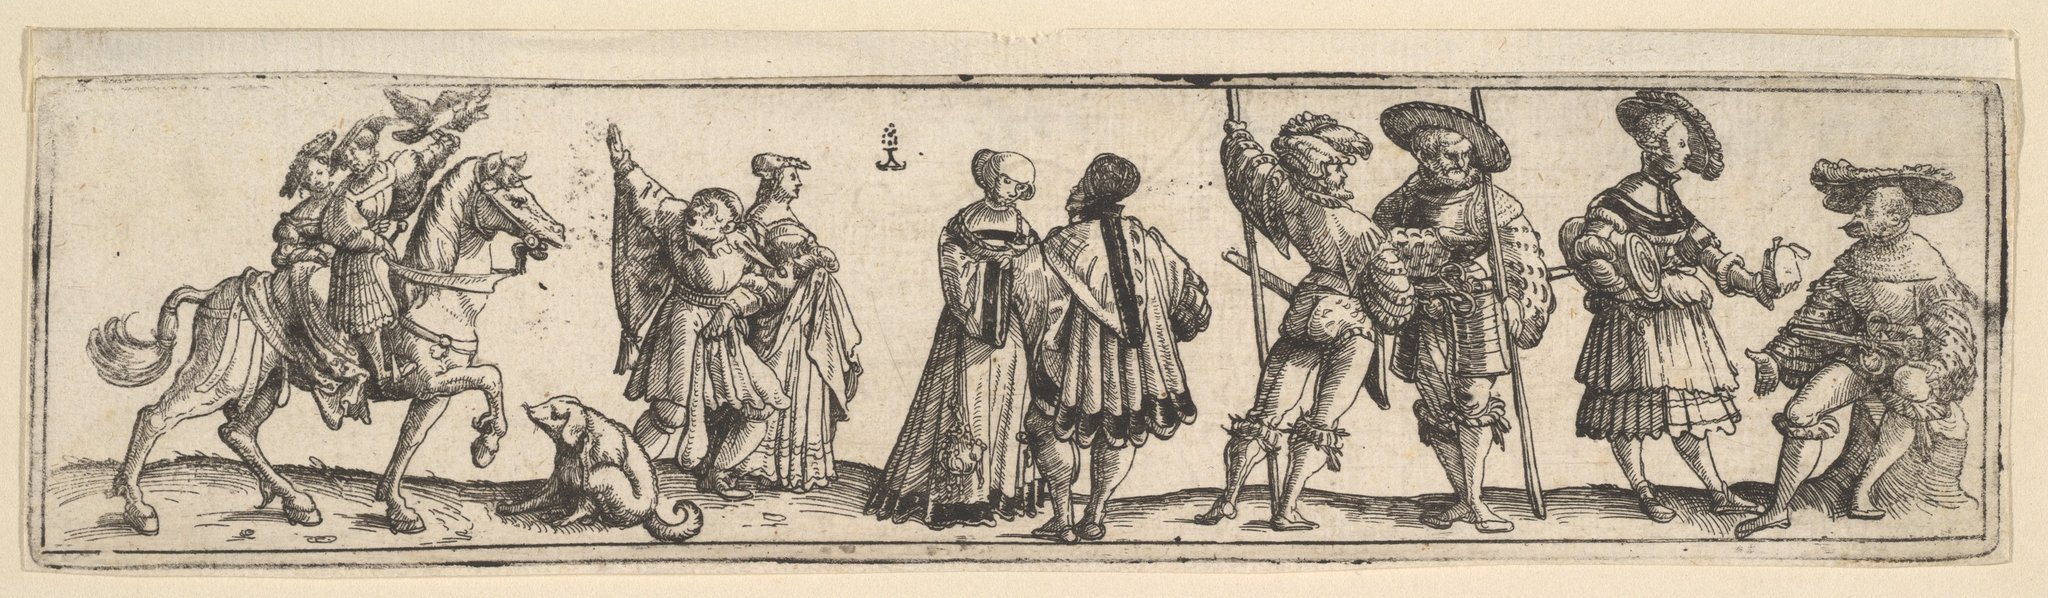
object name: print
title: Lansquenets and ladies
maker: christoph bockstorffer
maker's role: artist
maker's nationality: german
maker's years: 1475-1558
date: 1531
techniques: etching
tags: birds,men,women,horses